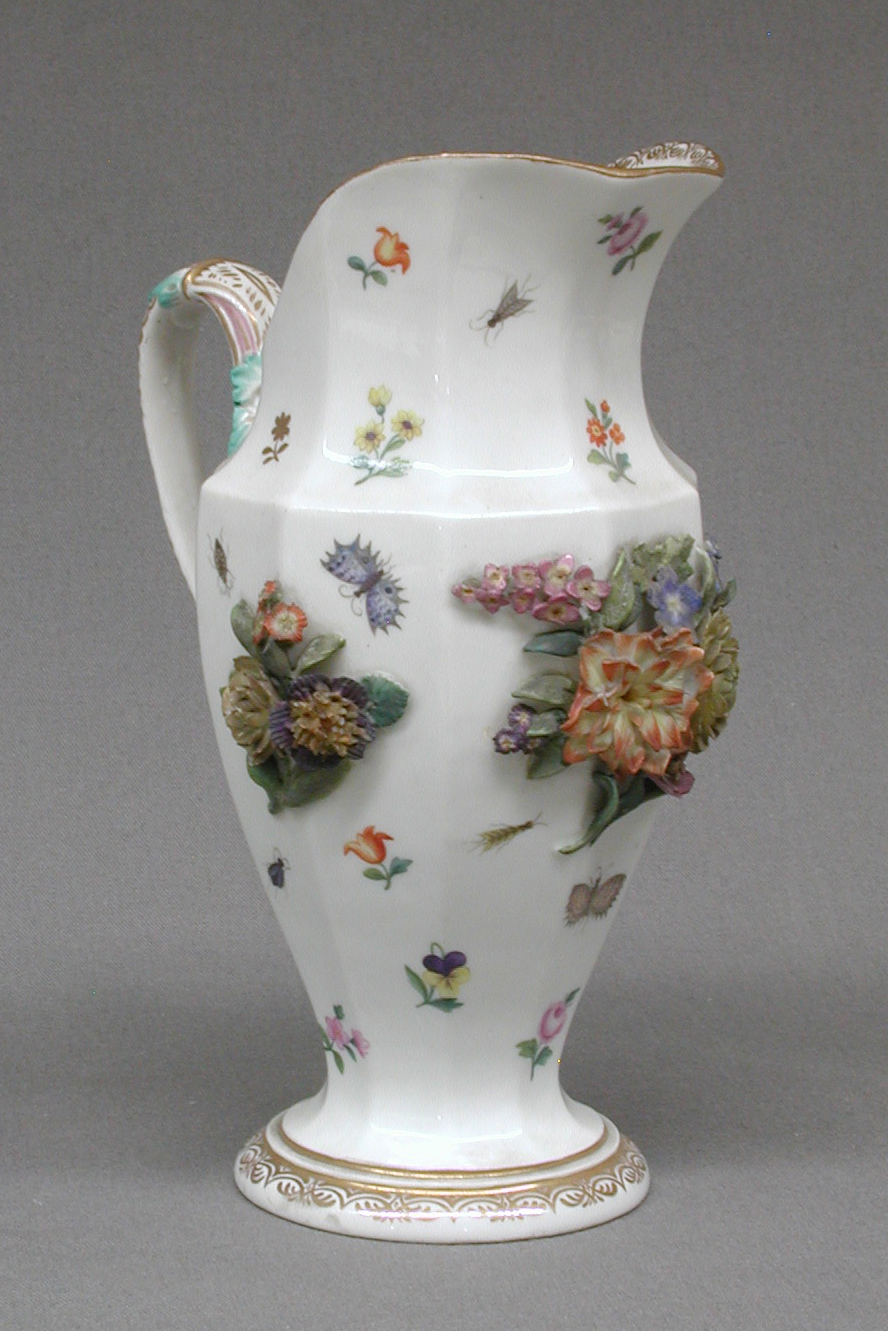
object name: creamer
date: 1801-1900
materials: hard paste porcelain